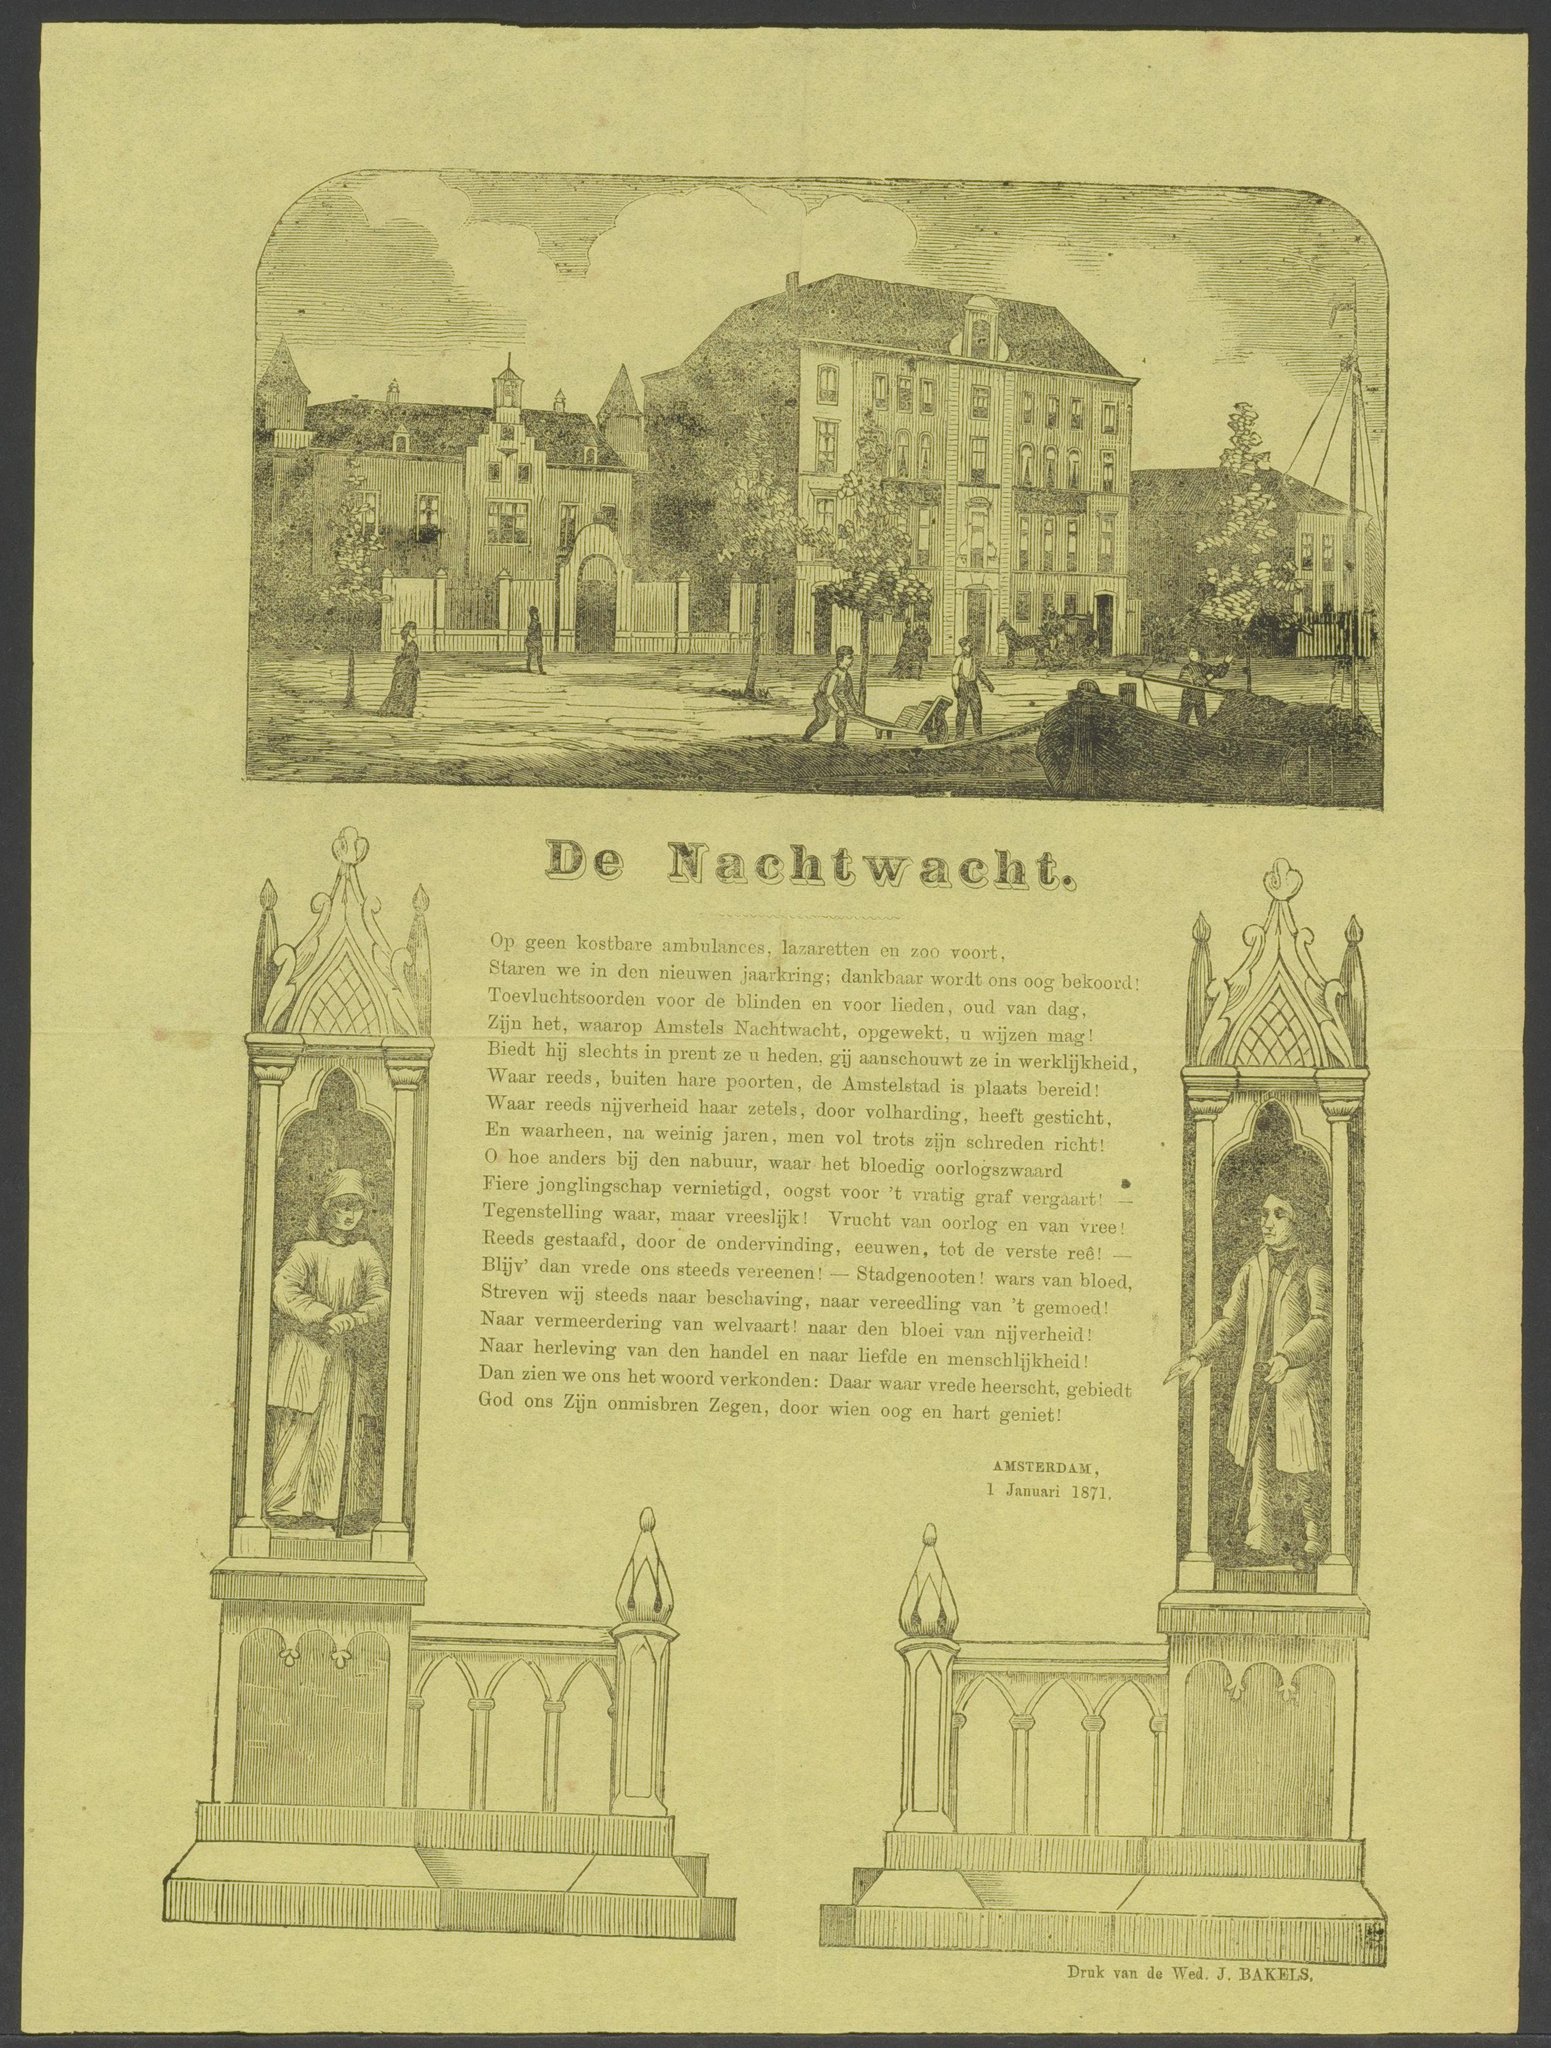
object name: new year card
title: De Nachtwacht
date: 1870-1871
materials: paper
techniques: letterpress printing, engraving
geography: amsterdam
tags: night patrol, specialized institutions, blind, blindness, old-people's home, amsterdam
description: Nieuwjaarswens van de Amsterdamse nachtwacht (ratelwacht) voor het jaar 1871. Centraal een gedicht, bovenaan een gezicht op het Instituut voor Blinden (Stadhouderskade 84) en links daarvan het Henriëttehofje (Stadhouderskade 85). Aan weerszijden van het gedicht beelden van een staande blinde man en vrouw in een nis. De tekst van het gedicht refereert aan de Frans-Duitse oorlog. Onderwerpsrubrieken binnen de Atlas Zeden en Gewoonten: Zeden en gewoonten in engeren zin, Volksleven, Volksbladen, Nieuwjaars- en Kerstwenschen, Amsterdam.